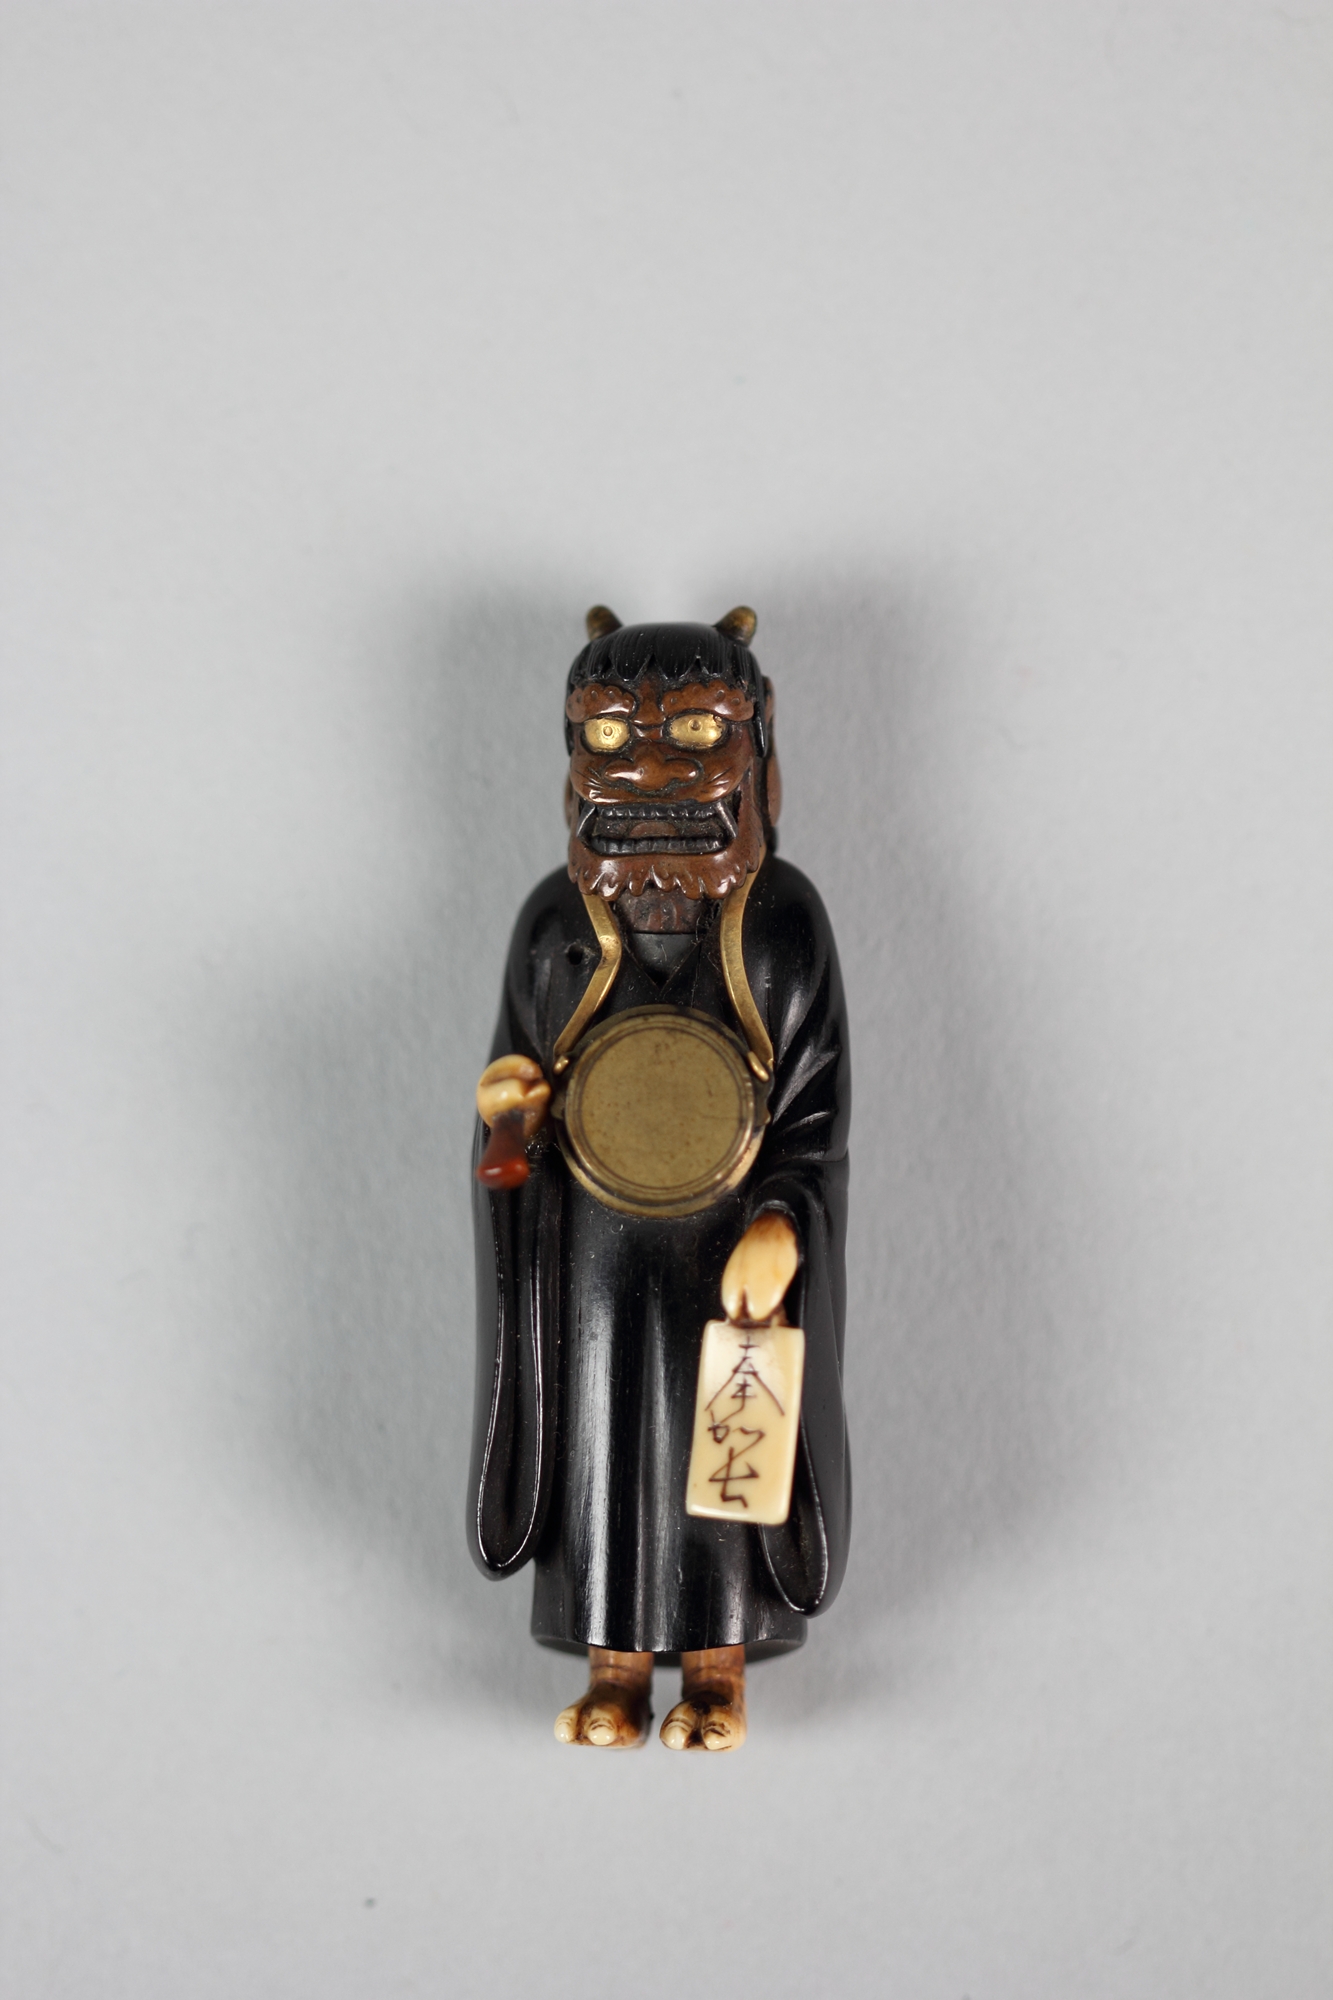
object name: netsuke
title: Netsuke of Demon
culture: japanese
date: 1767-1800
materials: brass, bronze, wood, ivory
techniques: inlay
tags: demons